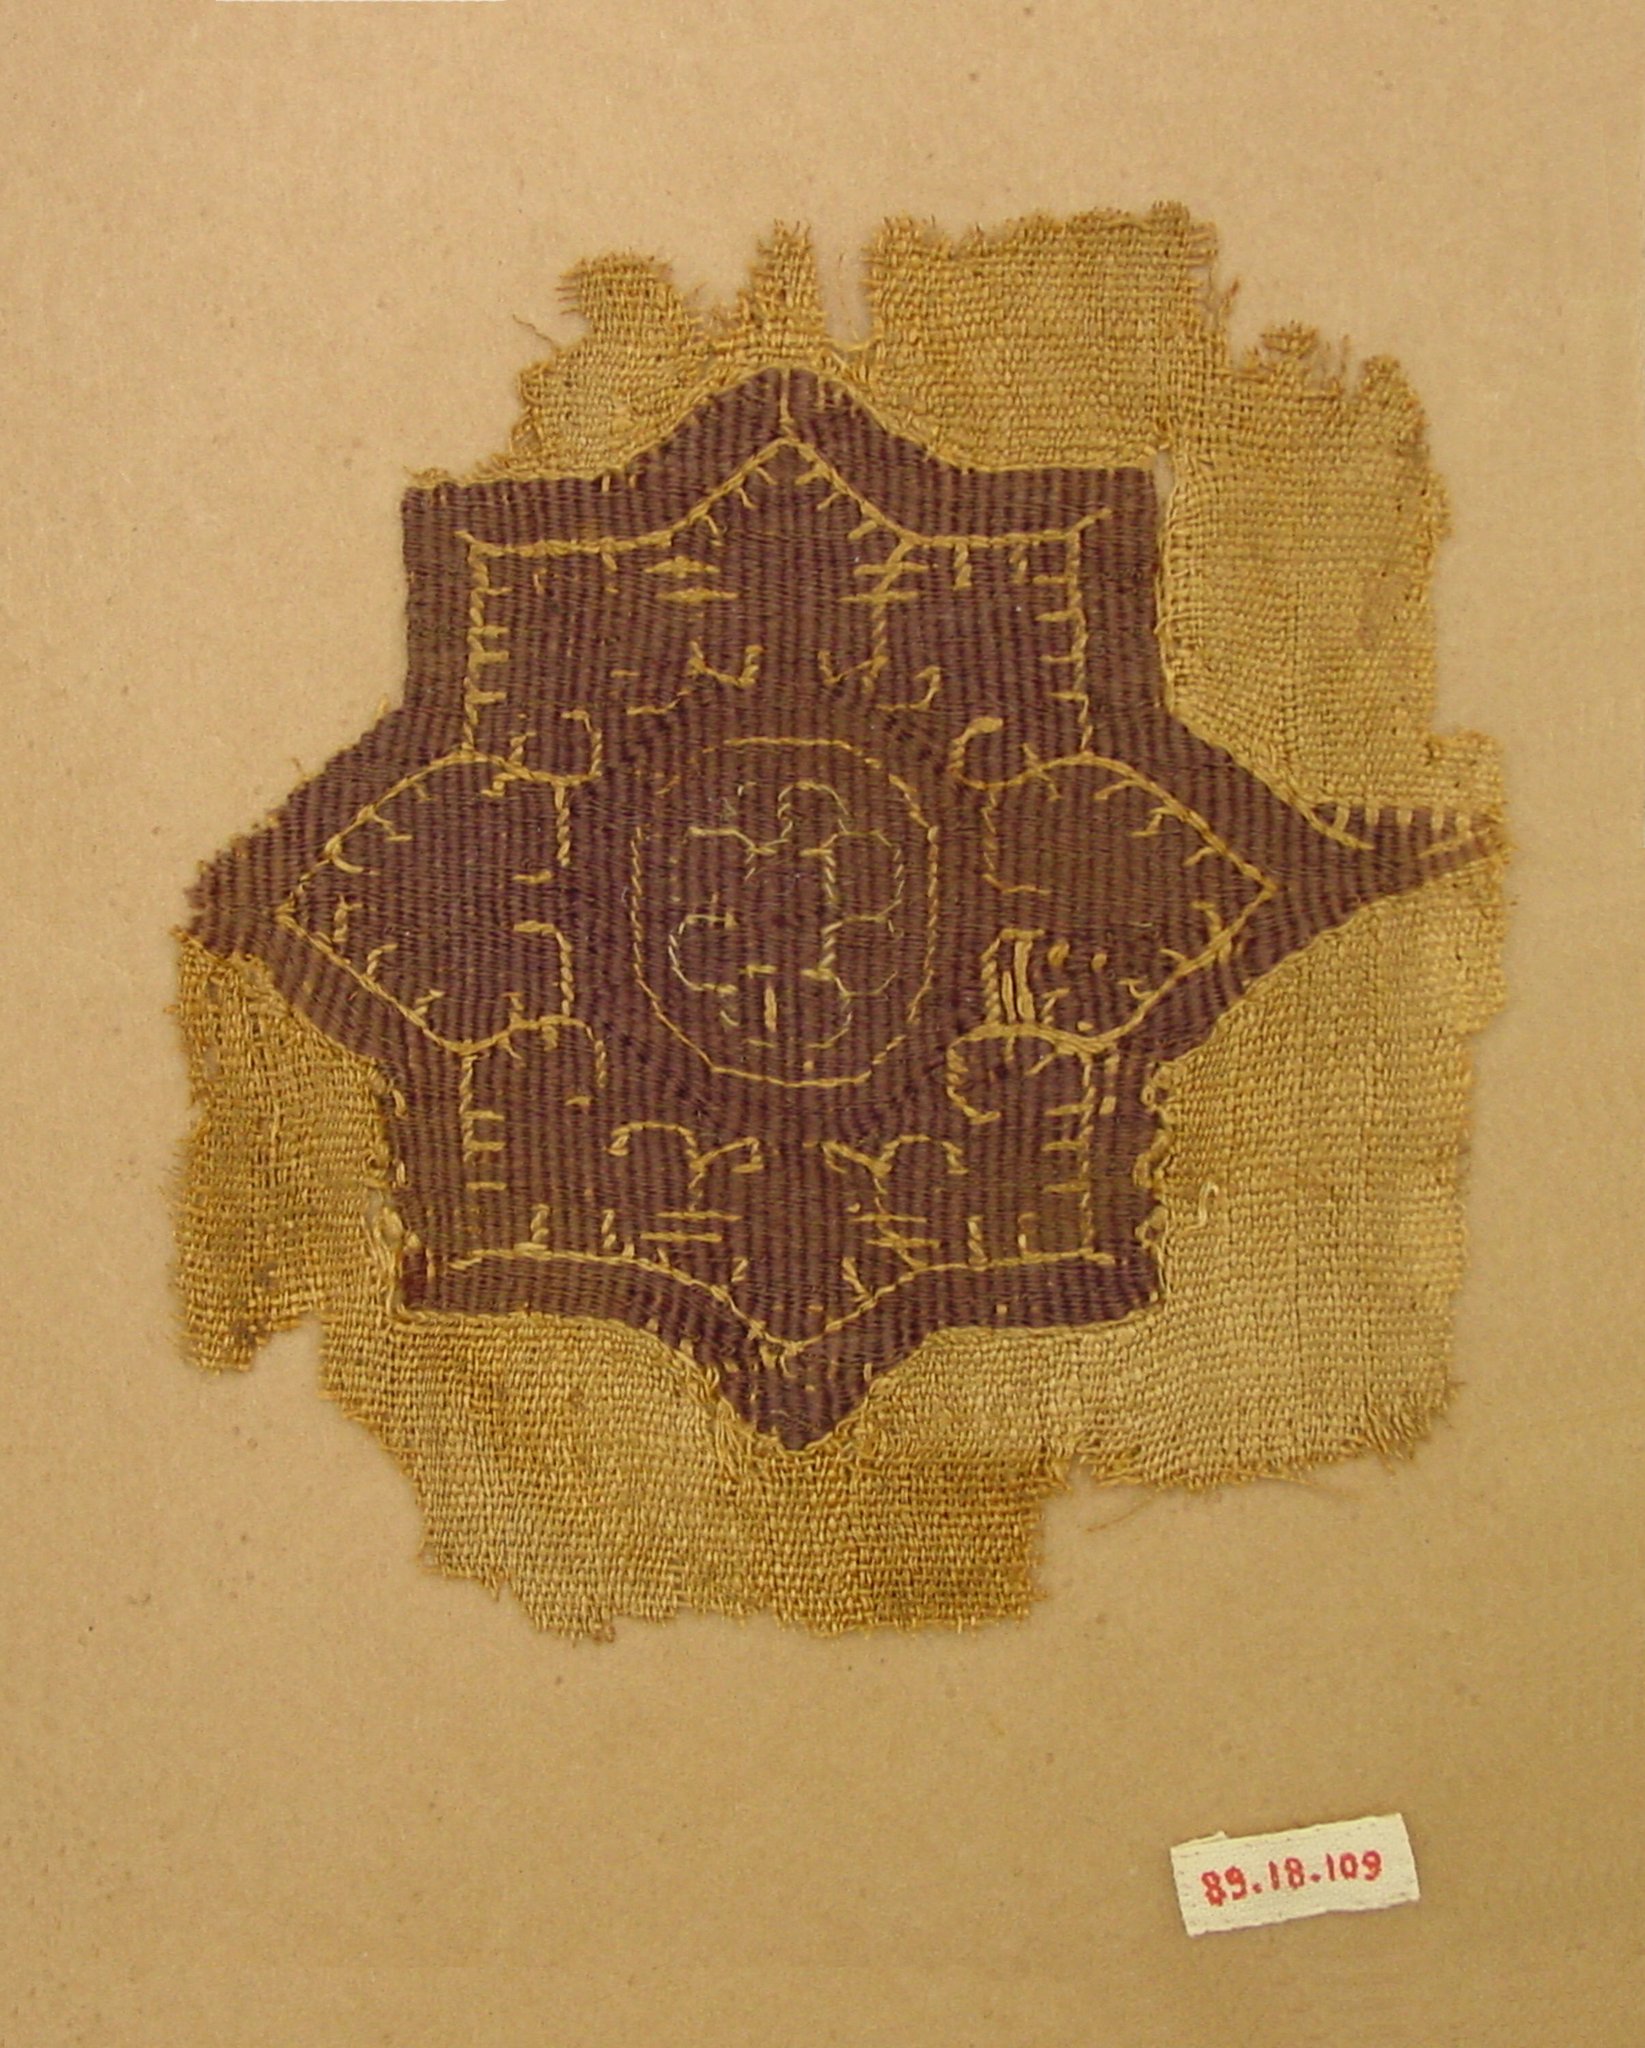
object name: textile fragment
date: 201-400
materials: linen, wool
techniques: weave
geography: egypt